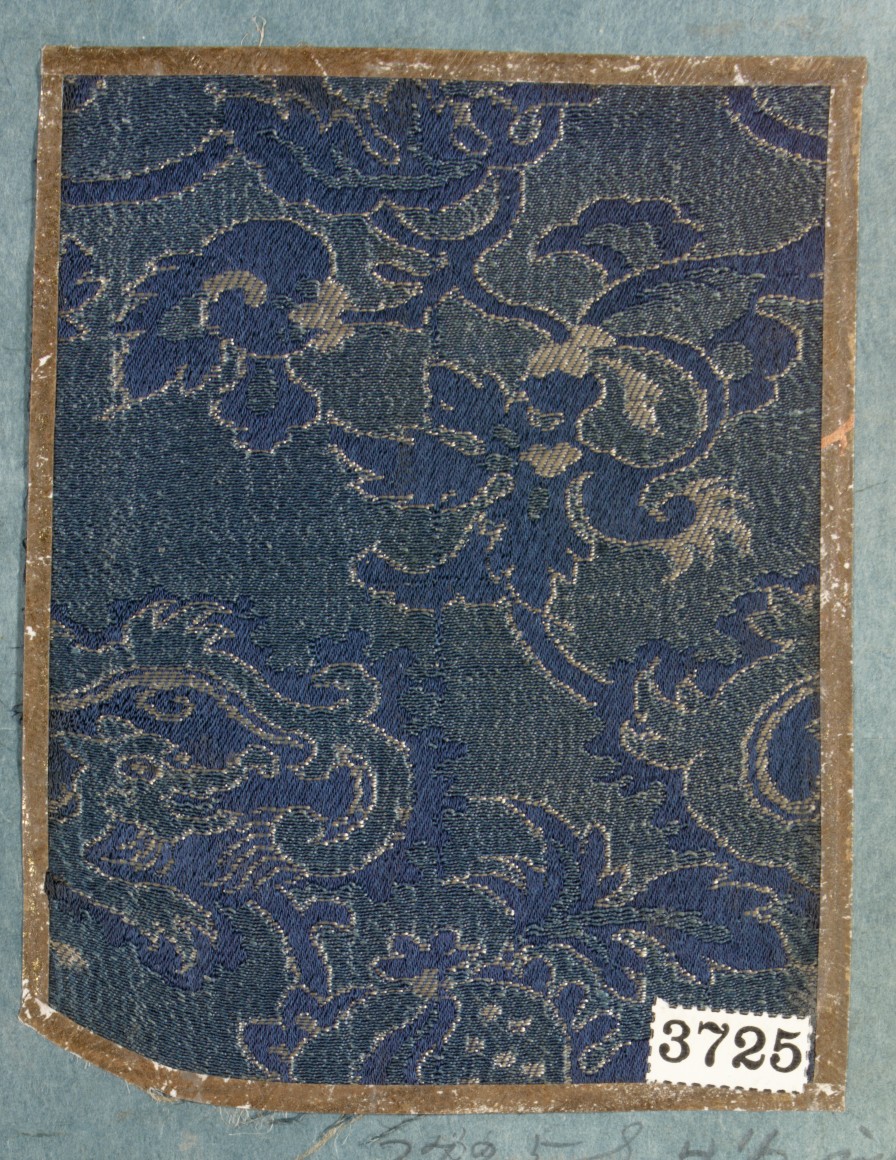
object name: sample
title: Textile Sample from Sample Book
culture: japanese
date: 1801-1900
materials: silk